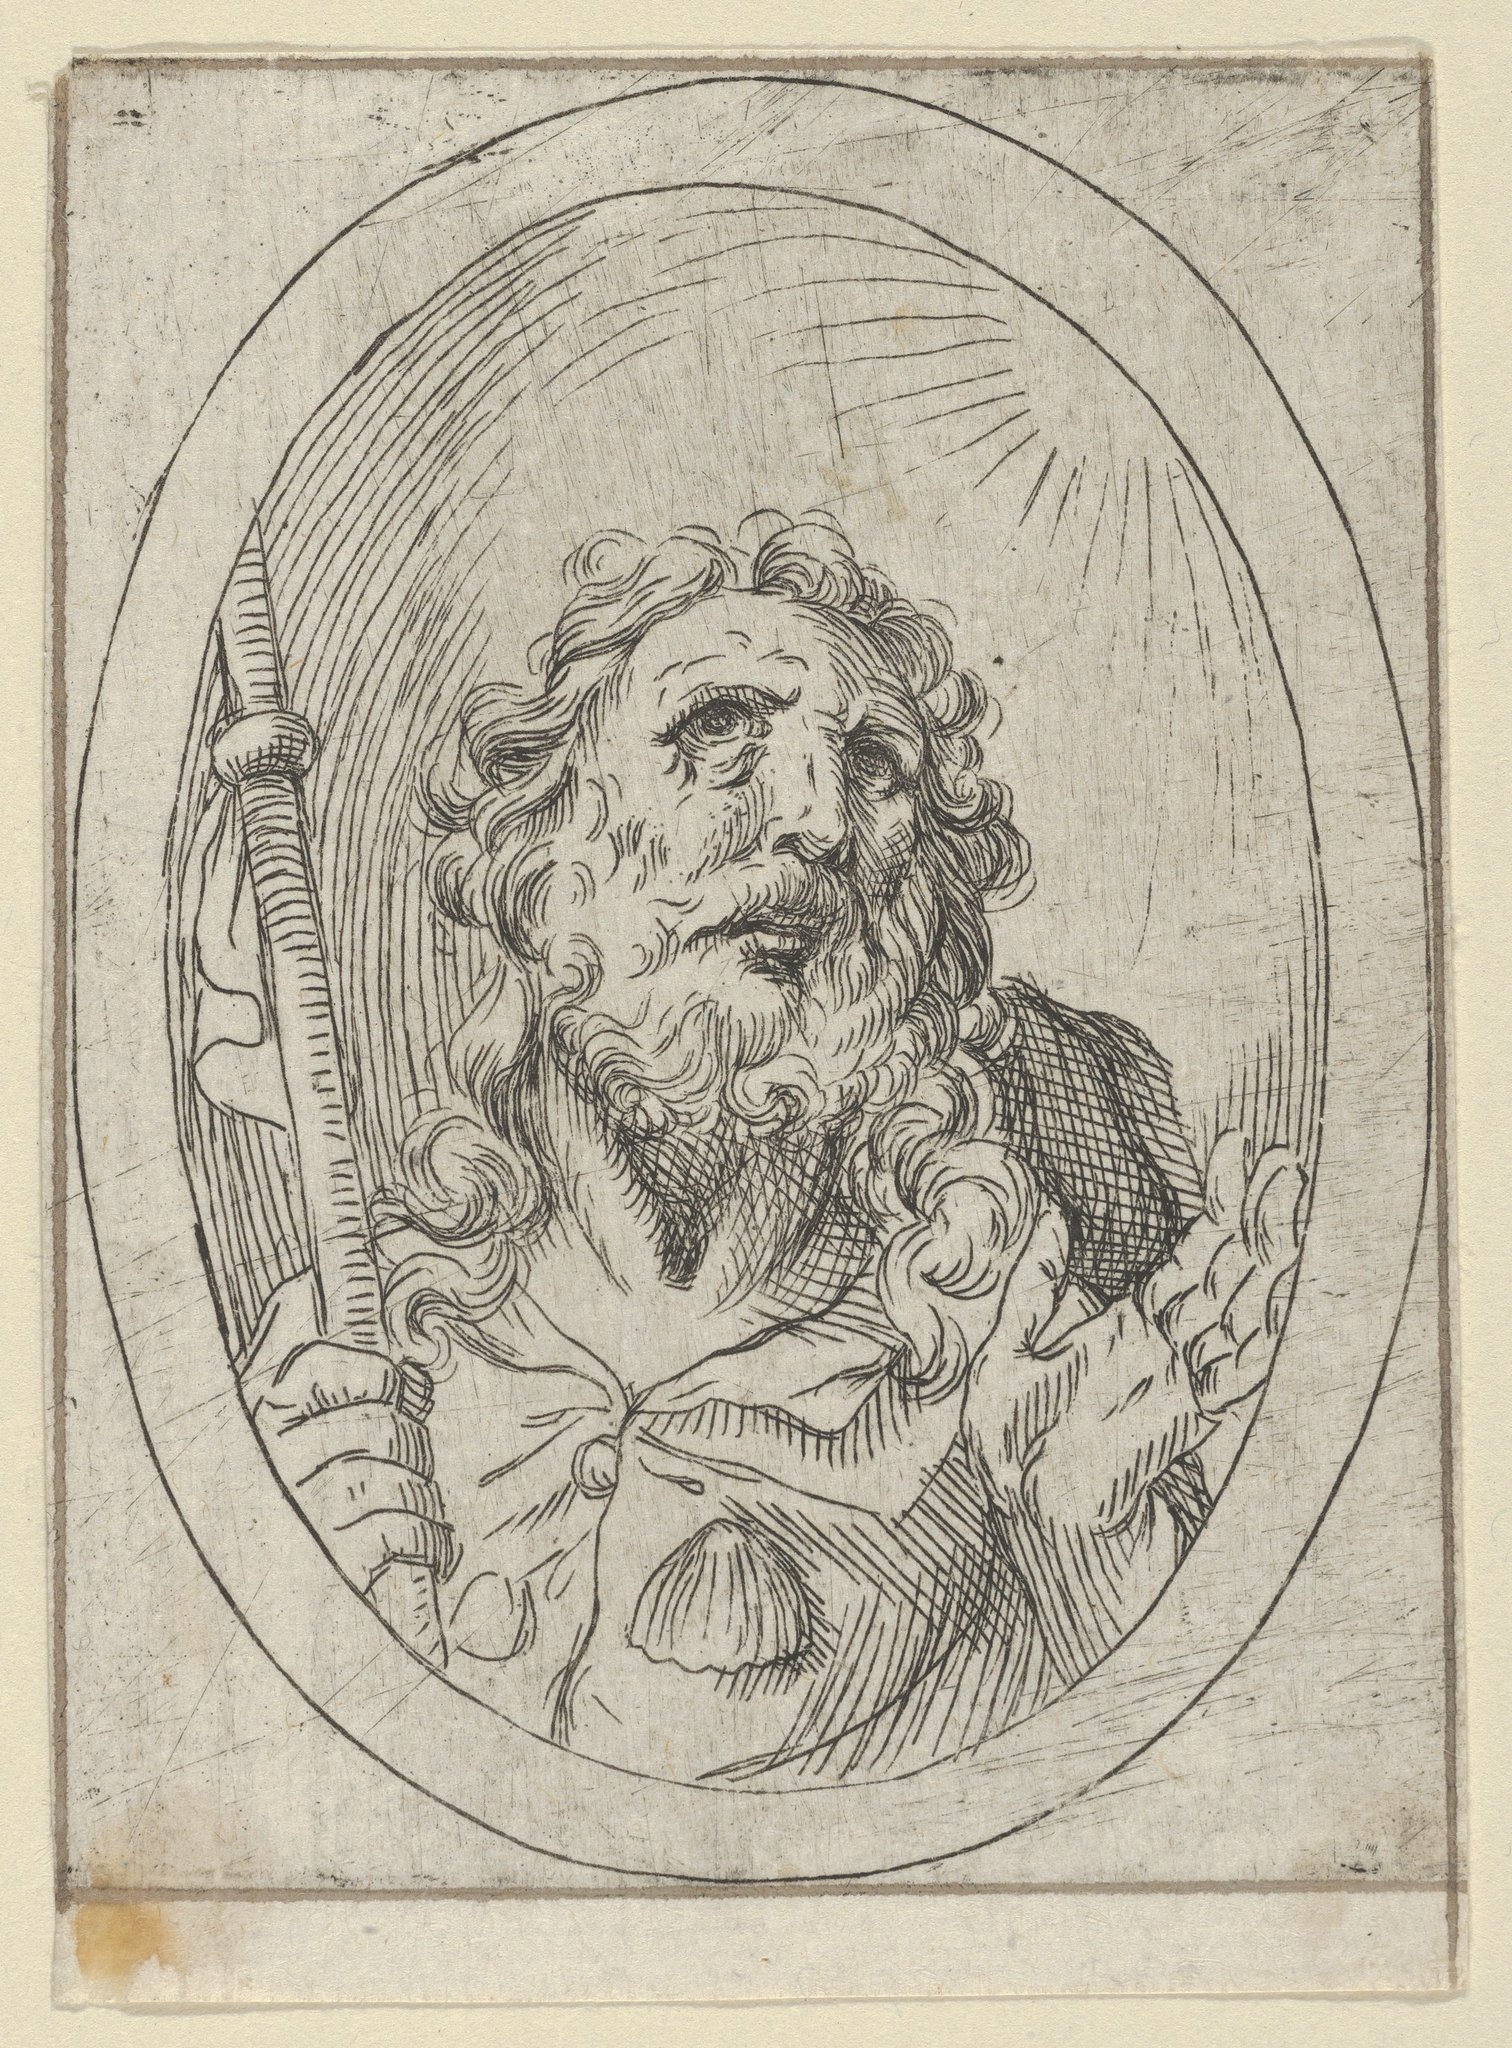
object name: print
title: Saint James Major, looking upwards and holding a staff, from "Christ, the Virgin, and Thirteen Apostles"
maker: anonymous, 17th century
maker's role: artist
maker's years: 1600-1700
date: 1600-1640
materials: ink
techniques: etching, pen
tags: saints